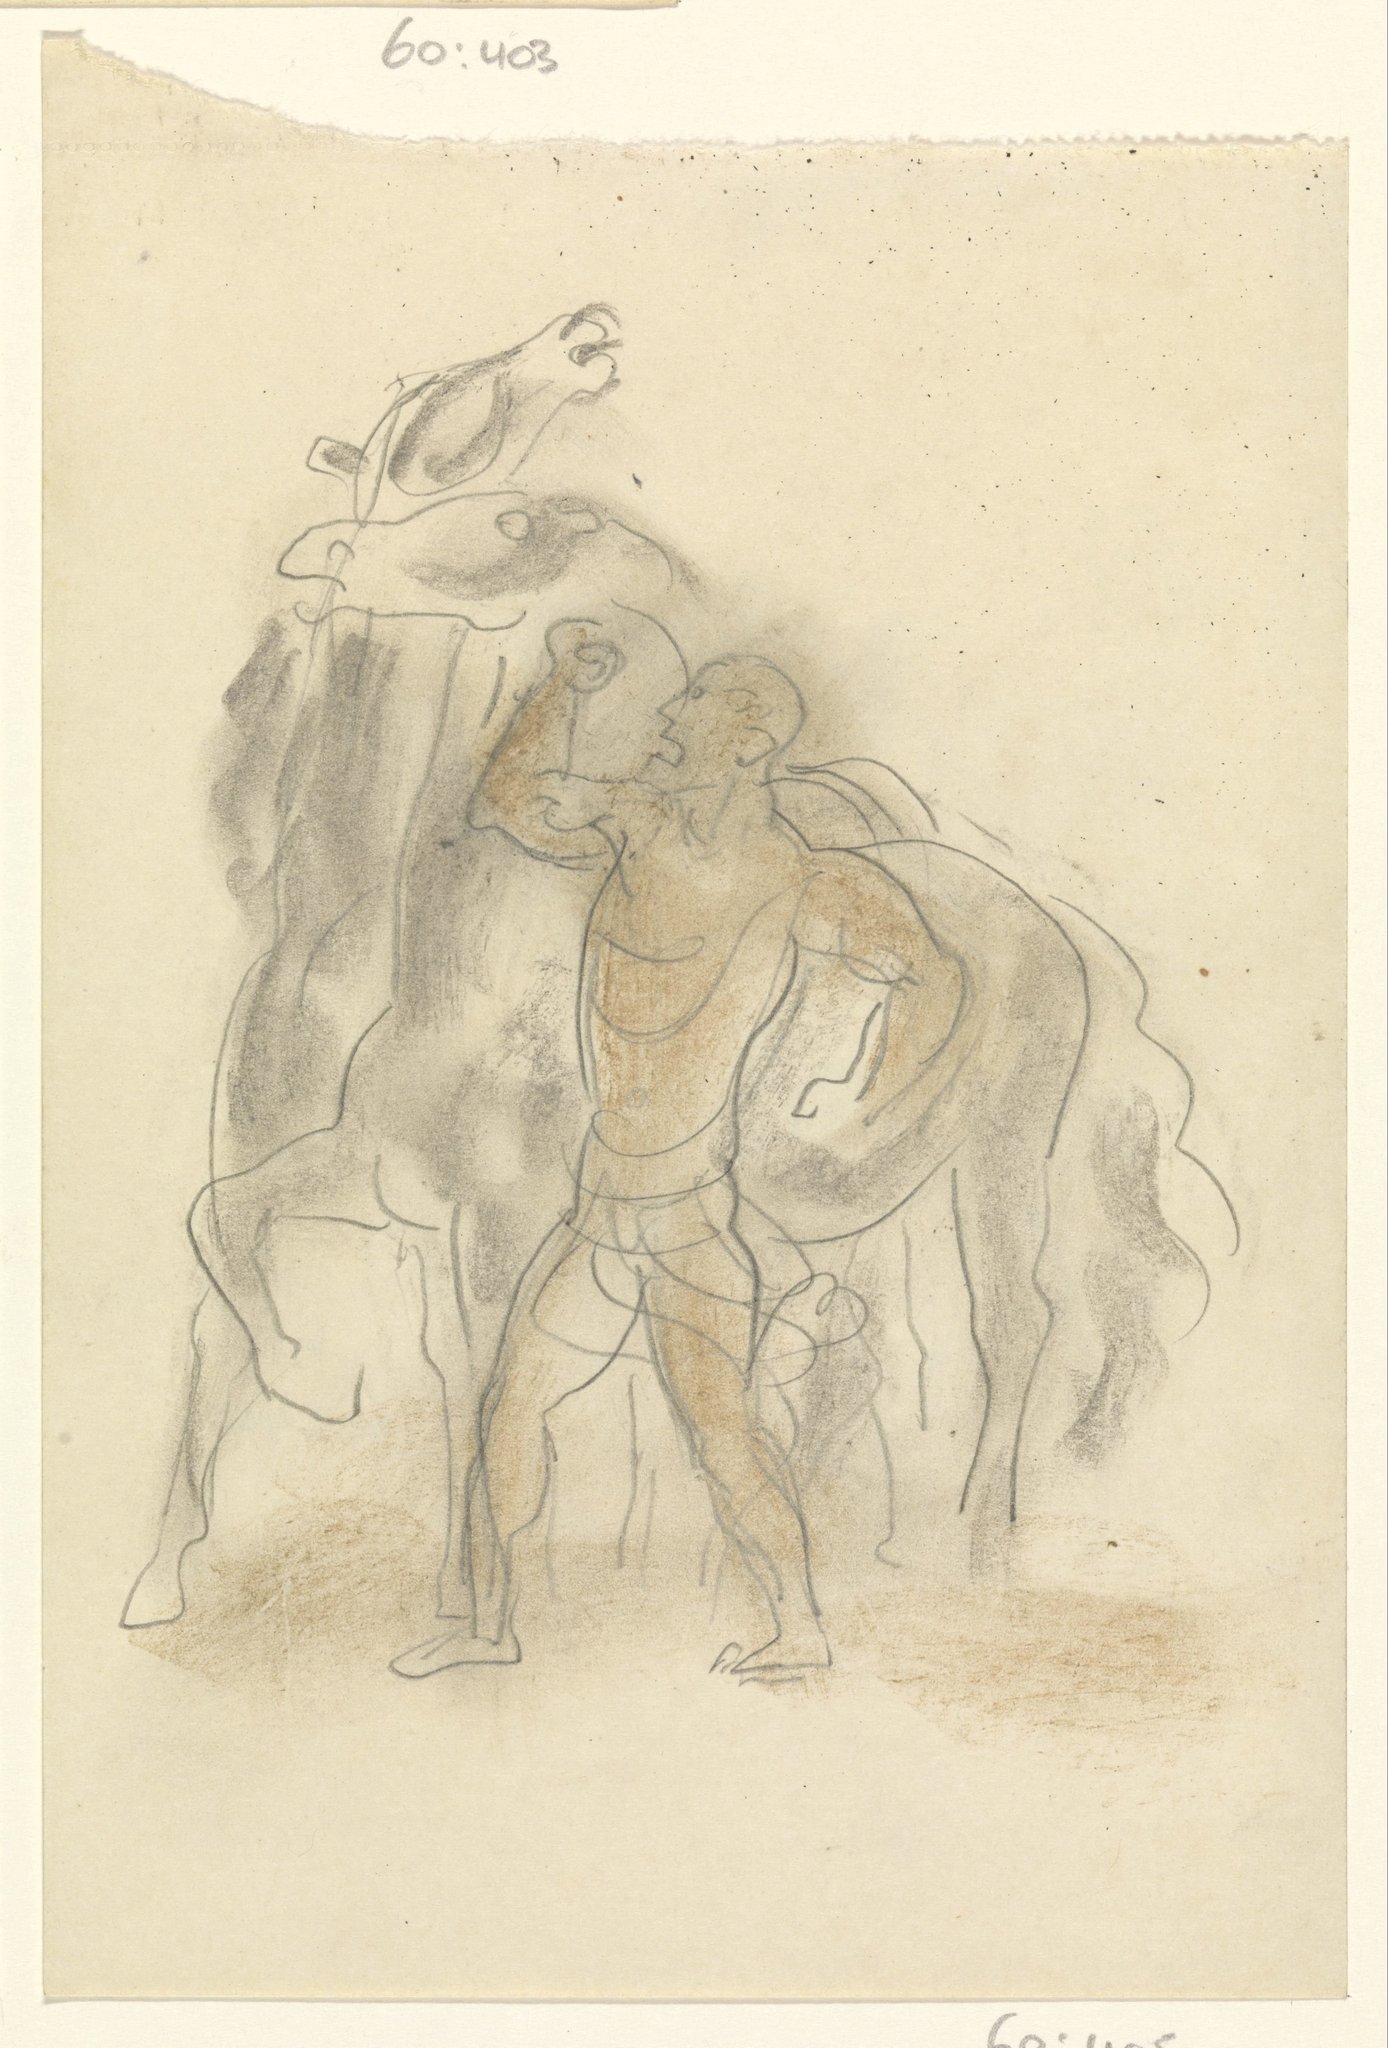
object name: drawing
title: Man houdt twee paarden in bedwang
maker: leo gestel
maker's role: draughtsman, print maker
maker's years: 1881-1941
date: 1891-1941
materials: chalk, paper, pencil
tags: standing figure (+ nude human being), horse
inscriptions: collector's mark: Lugt 2228